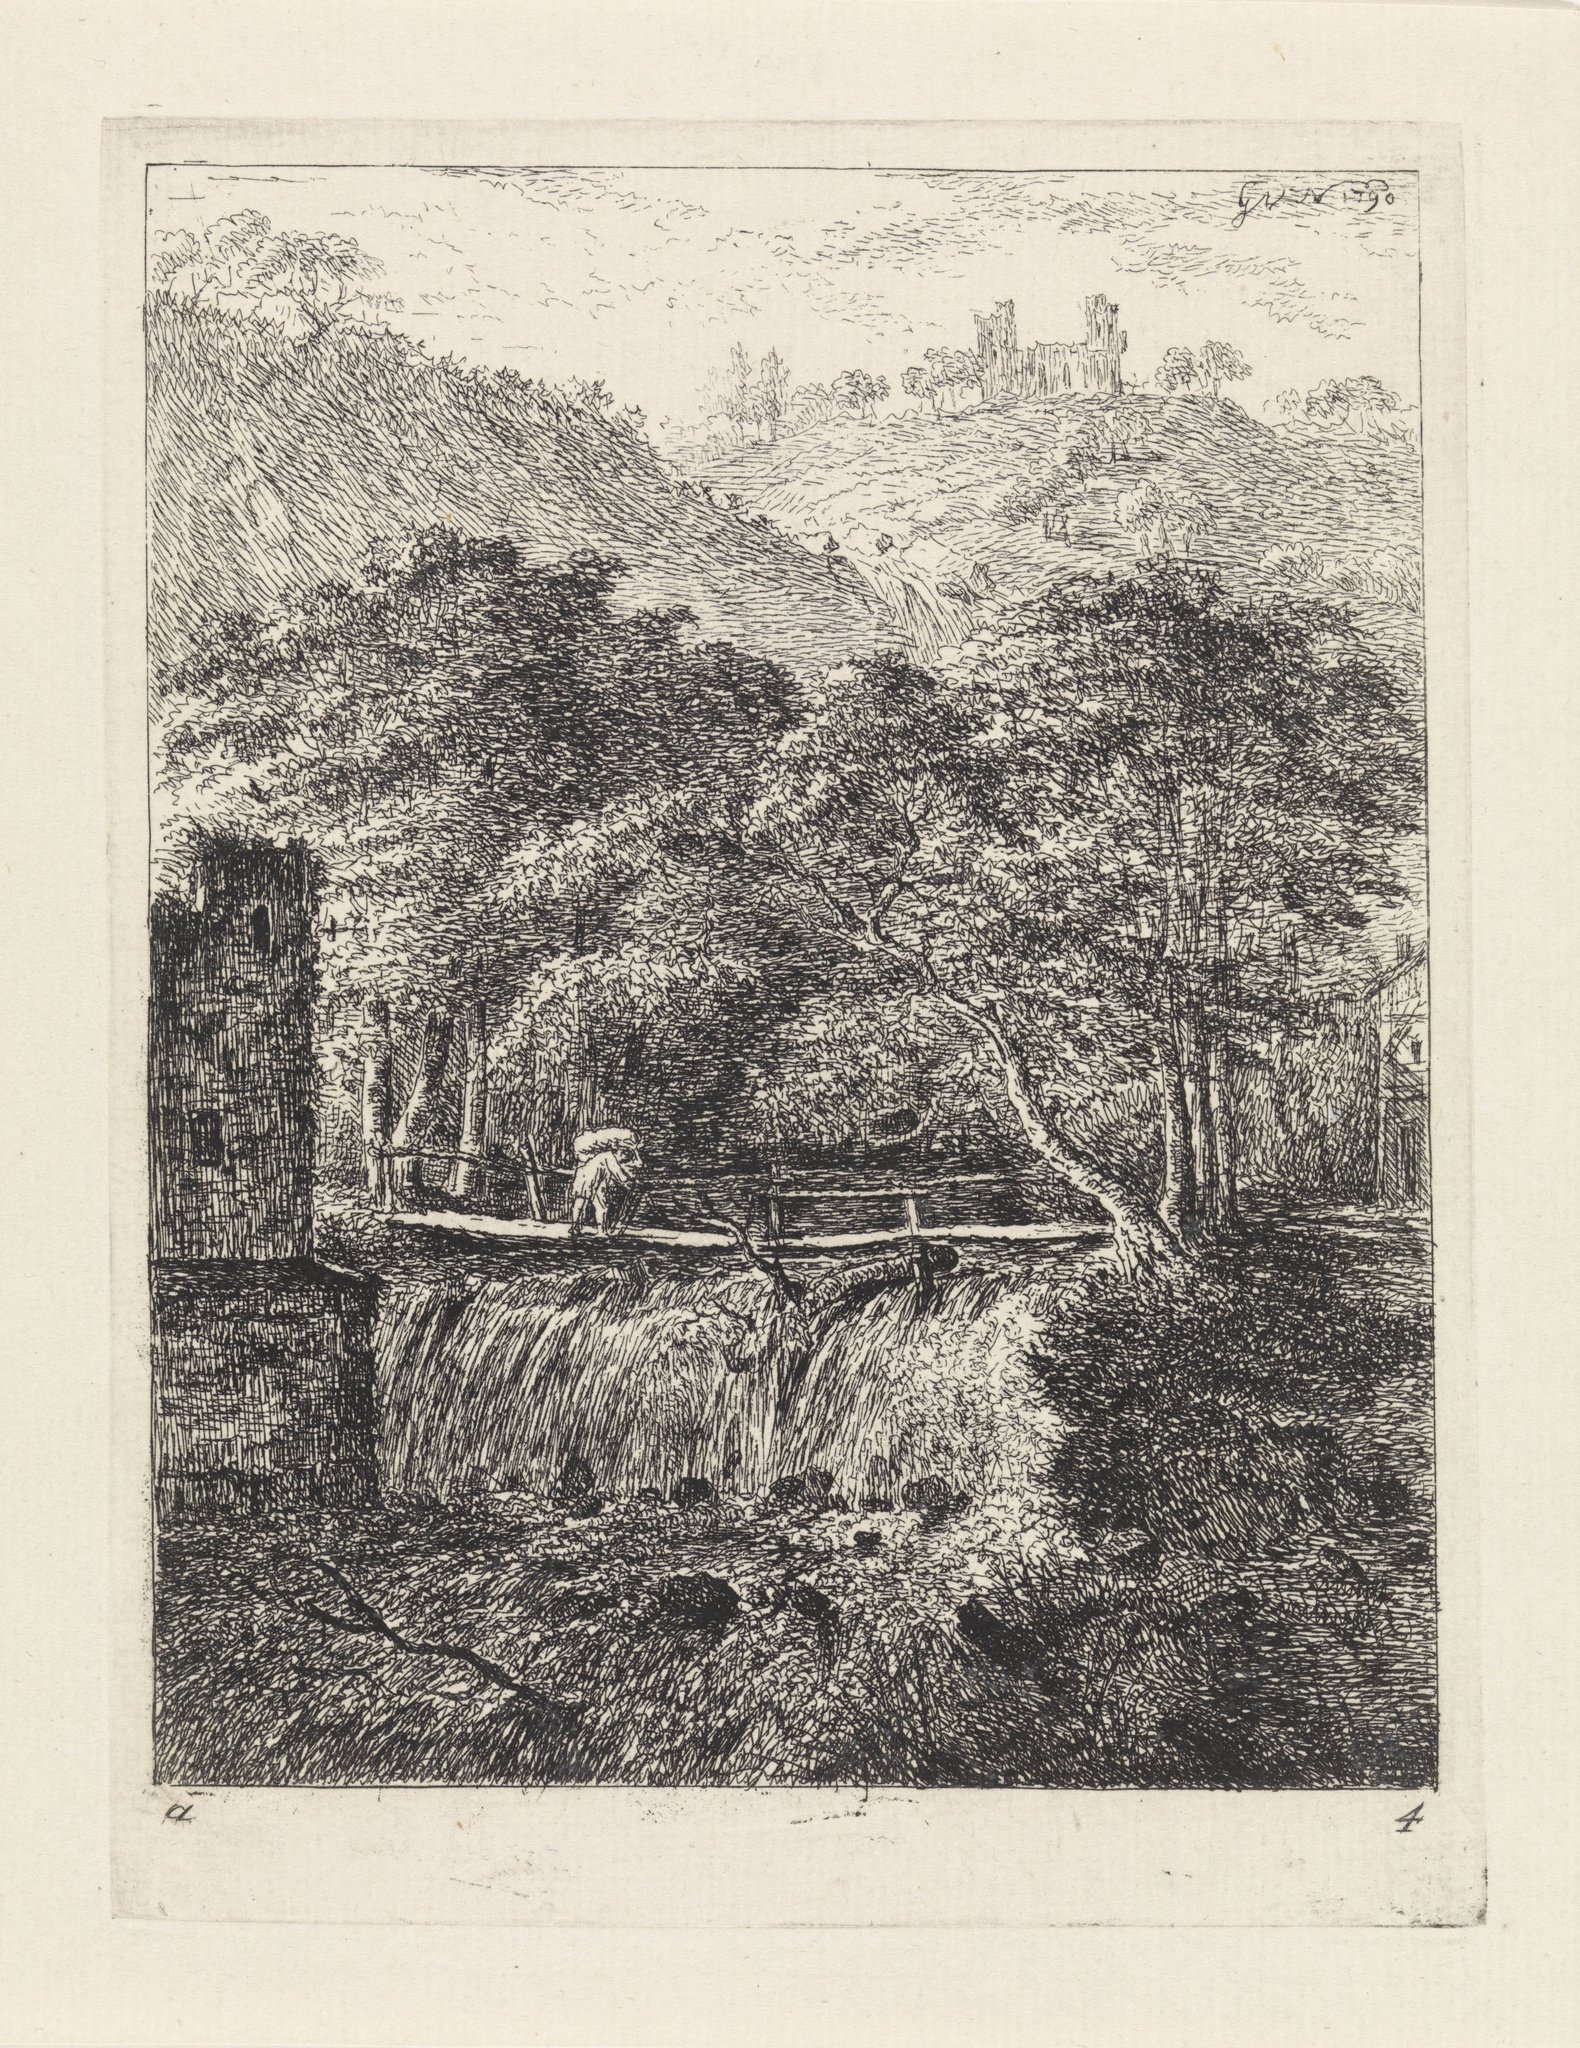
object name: print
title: Landschappen (serie A)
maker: gerard van nijmegen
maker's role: draughtsman, painter, print maker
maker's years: 1735-1808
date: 1790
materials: paper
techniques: etching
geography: rotterdam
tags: waterfall, bridge, carrying something on the head or on the shoulders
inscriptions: collector's mark: Lugt 2228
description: Heuvelachtig landschap met een brug boven een waterval, waarover een man loopt met een pak op zijn rug. Linksonder: a.